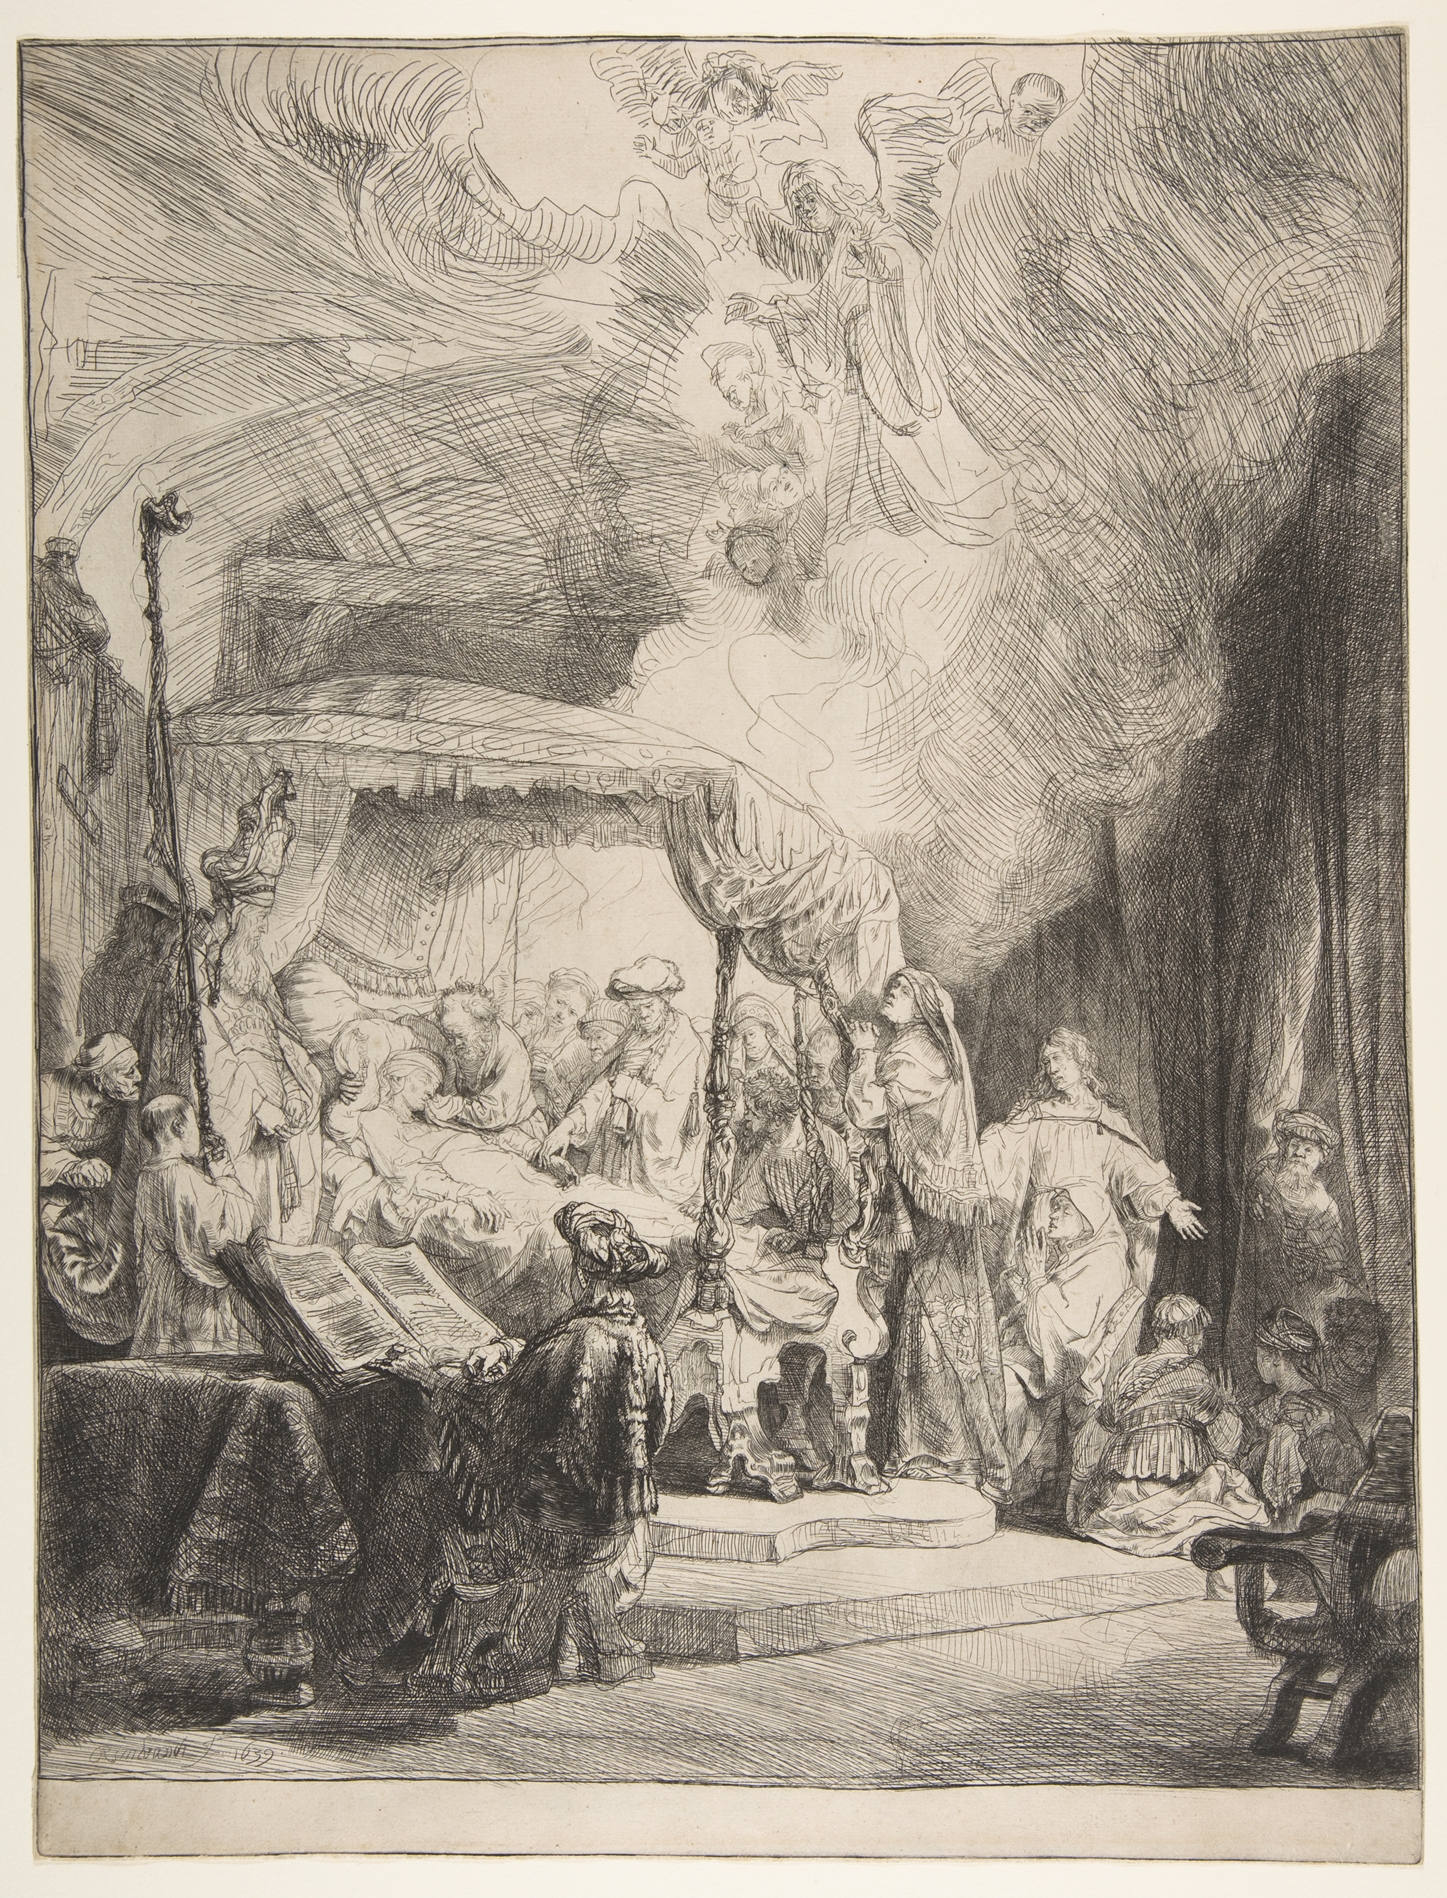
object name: print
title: The Death of the Virgin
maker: rembrandt van rijn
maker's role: artist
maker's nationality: dutch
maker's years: 1606-1669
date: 1639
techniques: drypoint, etching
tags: virgin mary,death